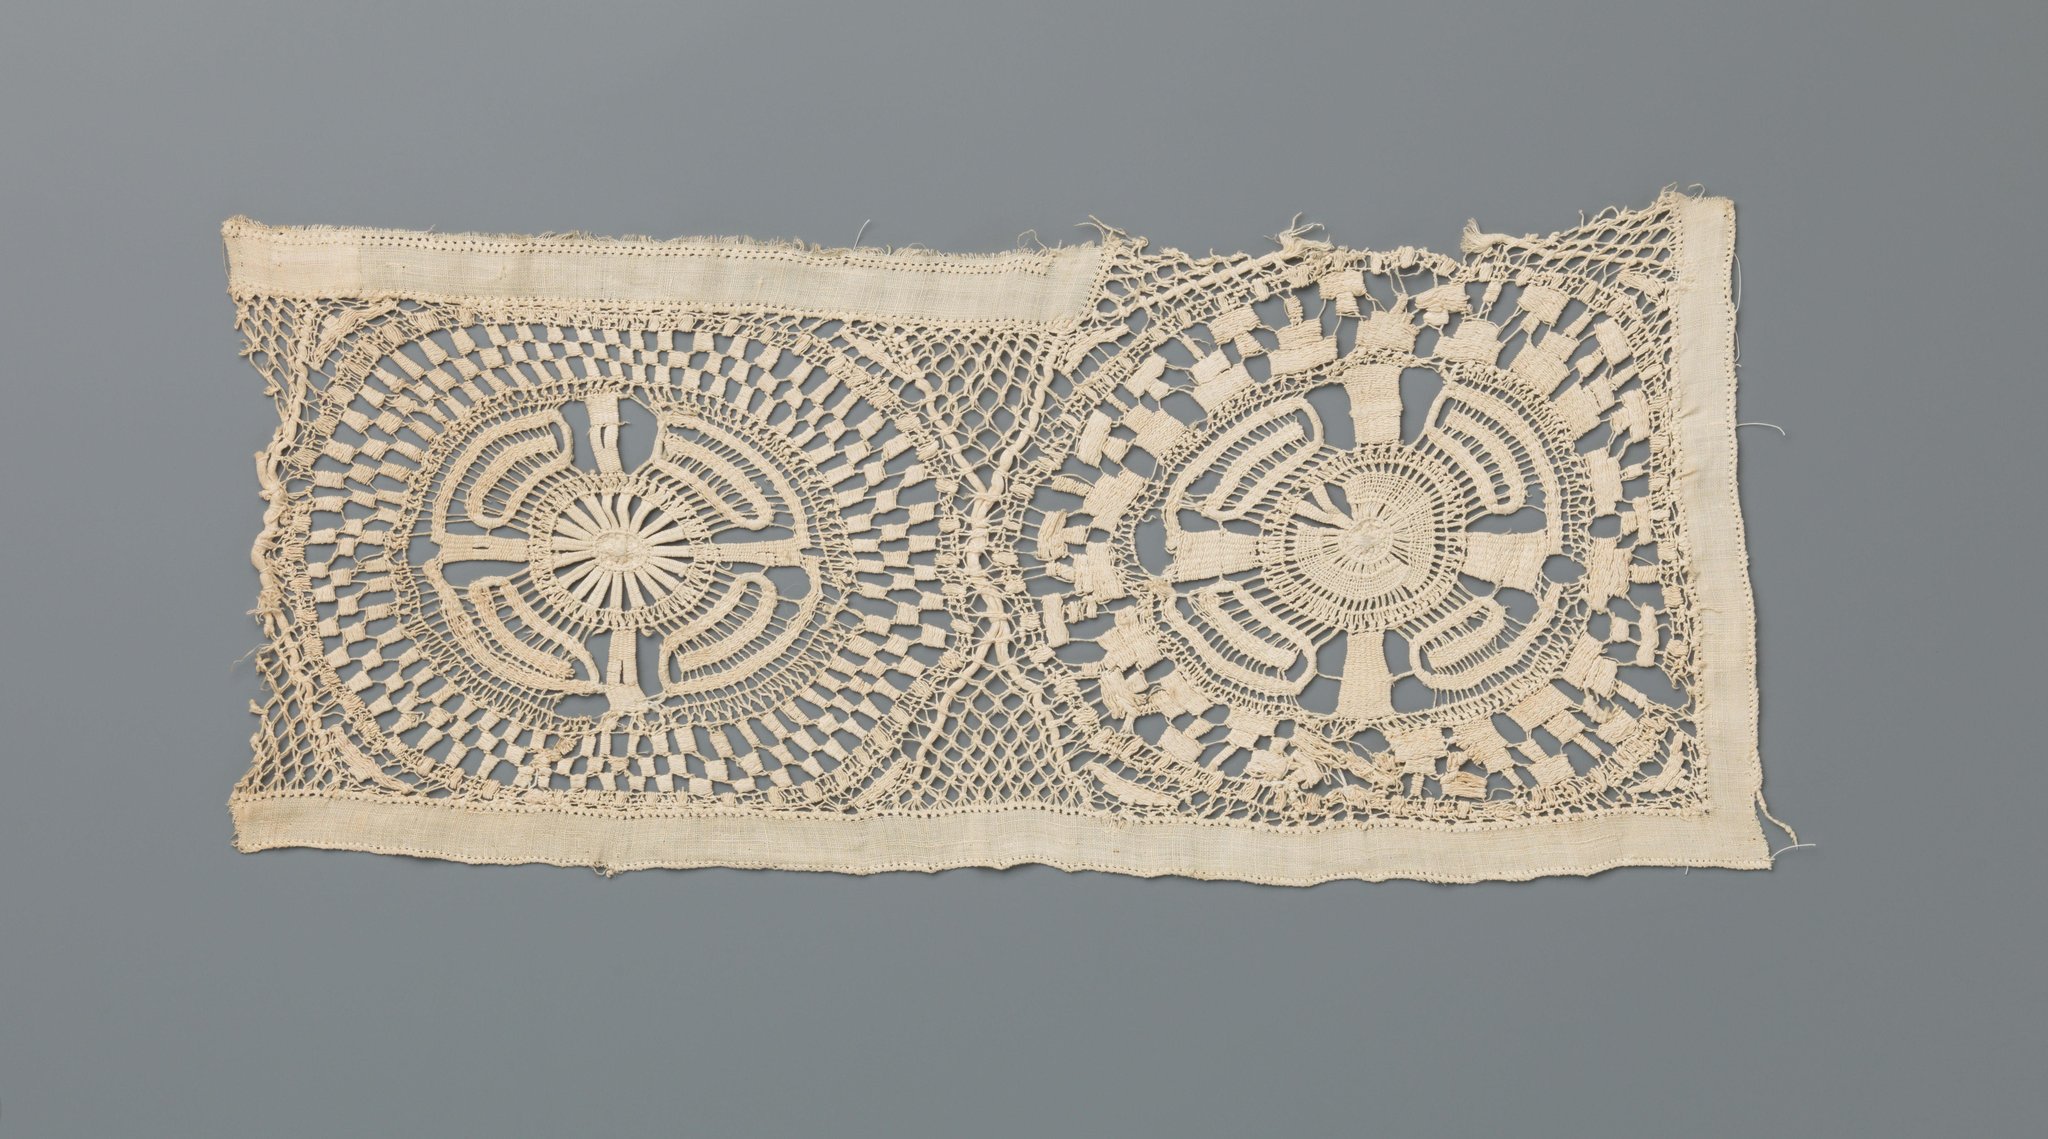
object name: fragment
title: Fragment naaldkant met twee zonnen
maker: Anonymous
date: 1700-1799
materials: linen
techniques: lace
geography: spain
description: Fragment naturelkleurige zonnekant (naaldkant): Tenerife-kant. Het fragment is rechthoekig en heeft een fragmentvullend patroon met twee 'zonnen'. Aan één korte en één lange zijde van het kant is een doorlopende rand linnen genaaid. Langs de andere lange zijde is boven één van de 'zonnen' ook een linnen rand genaaid, die een haakse hoek maakt, net voorbij de volgende zon. Het linnen is vlak boven het punt waar het een haakse hoek maakt afgeknipt, over dezelfde lijn als waar het kant een haakse hoek maakt, maar is afgeknipt. De andere korte zijde is ook afgeknipt en niet afgewerkt.